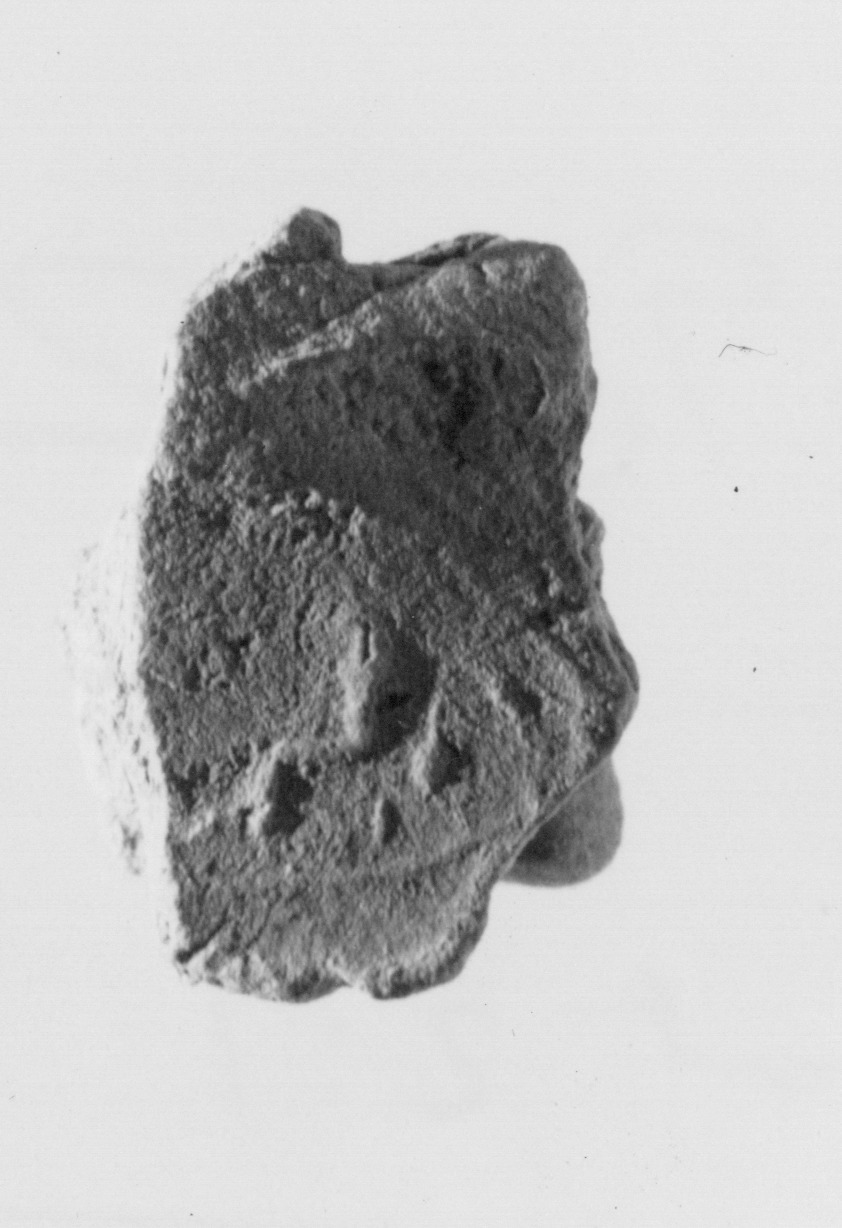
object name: sealing, re, queen, goddess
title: Document Sealing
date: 1390-1352 BCE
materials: mud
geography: egypt